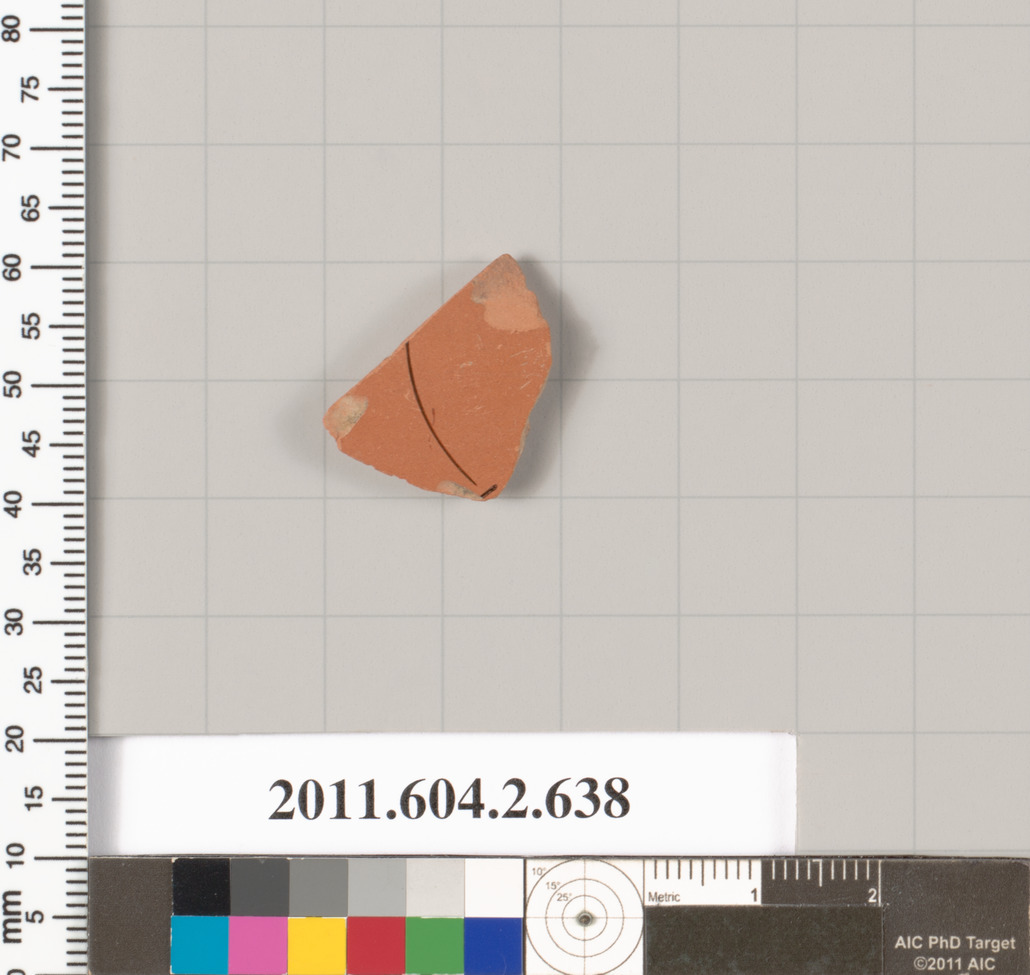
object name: pot fragment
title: Terracotta fragment of a pot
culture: greek, attic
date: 460-440 BCE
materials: terracotta